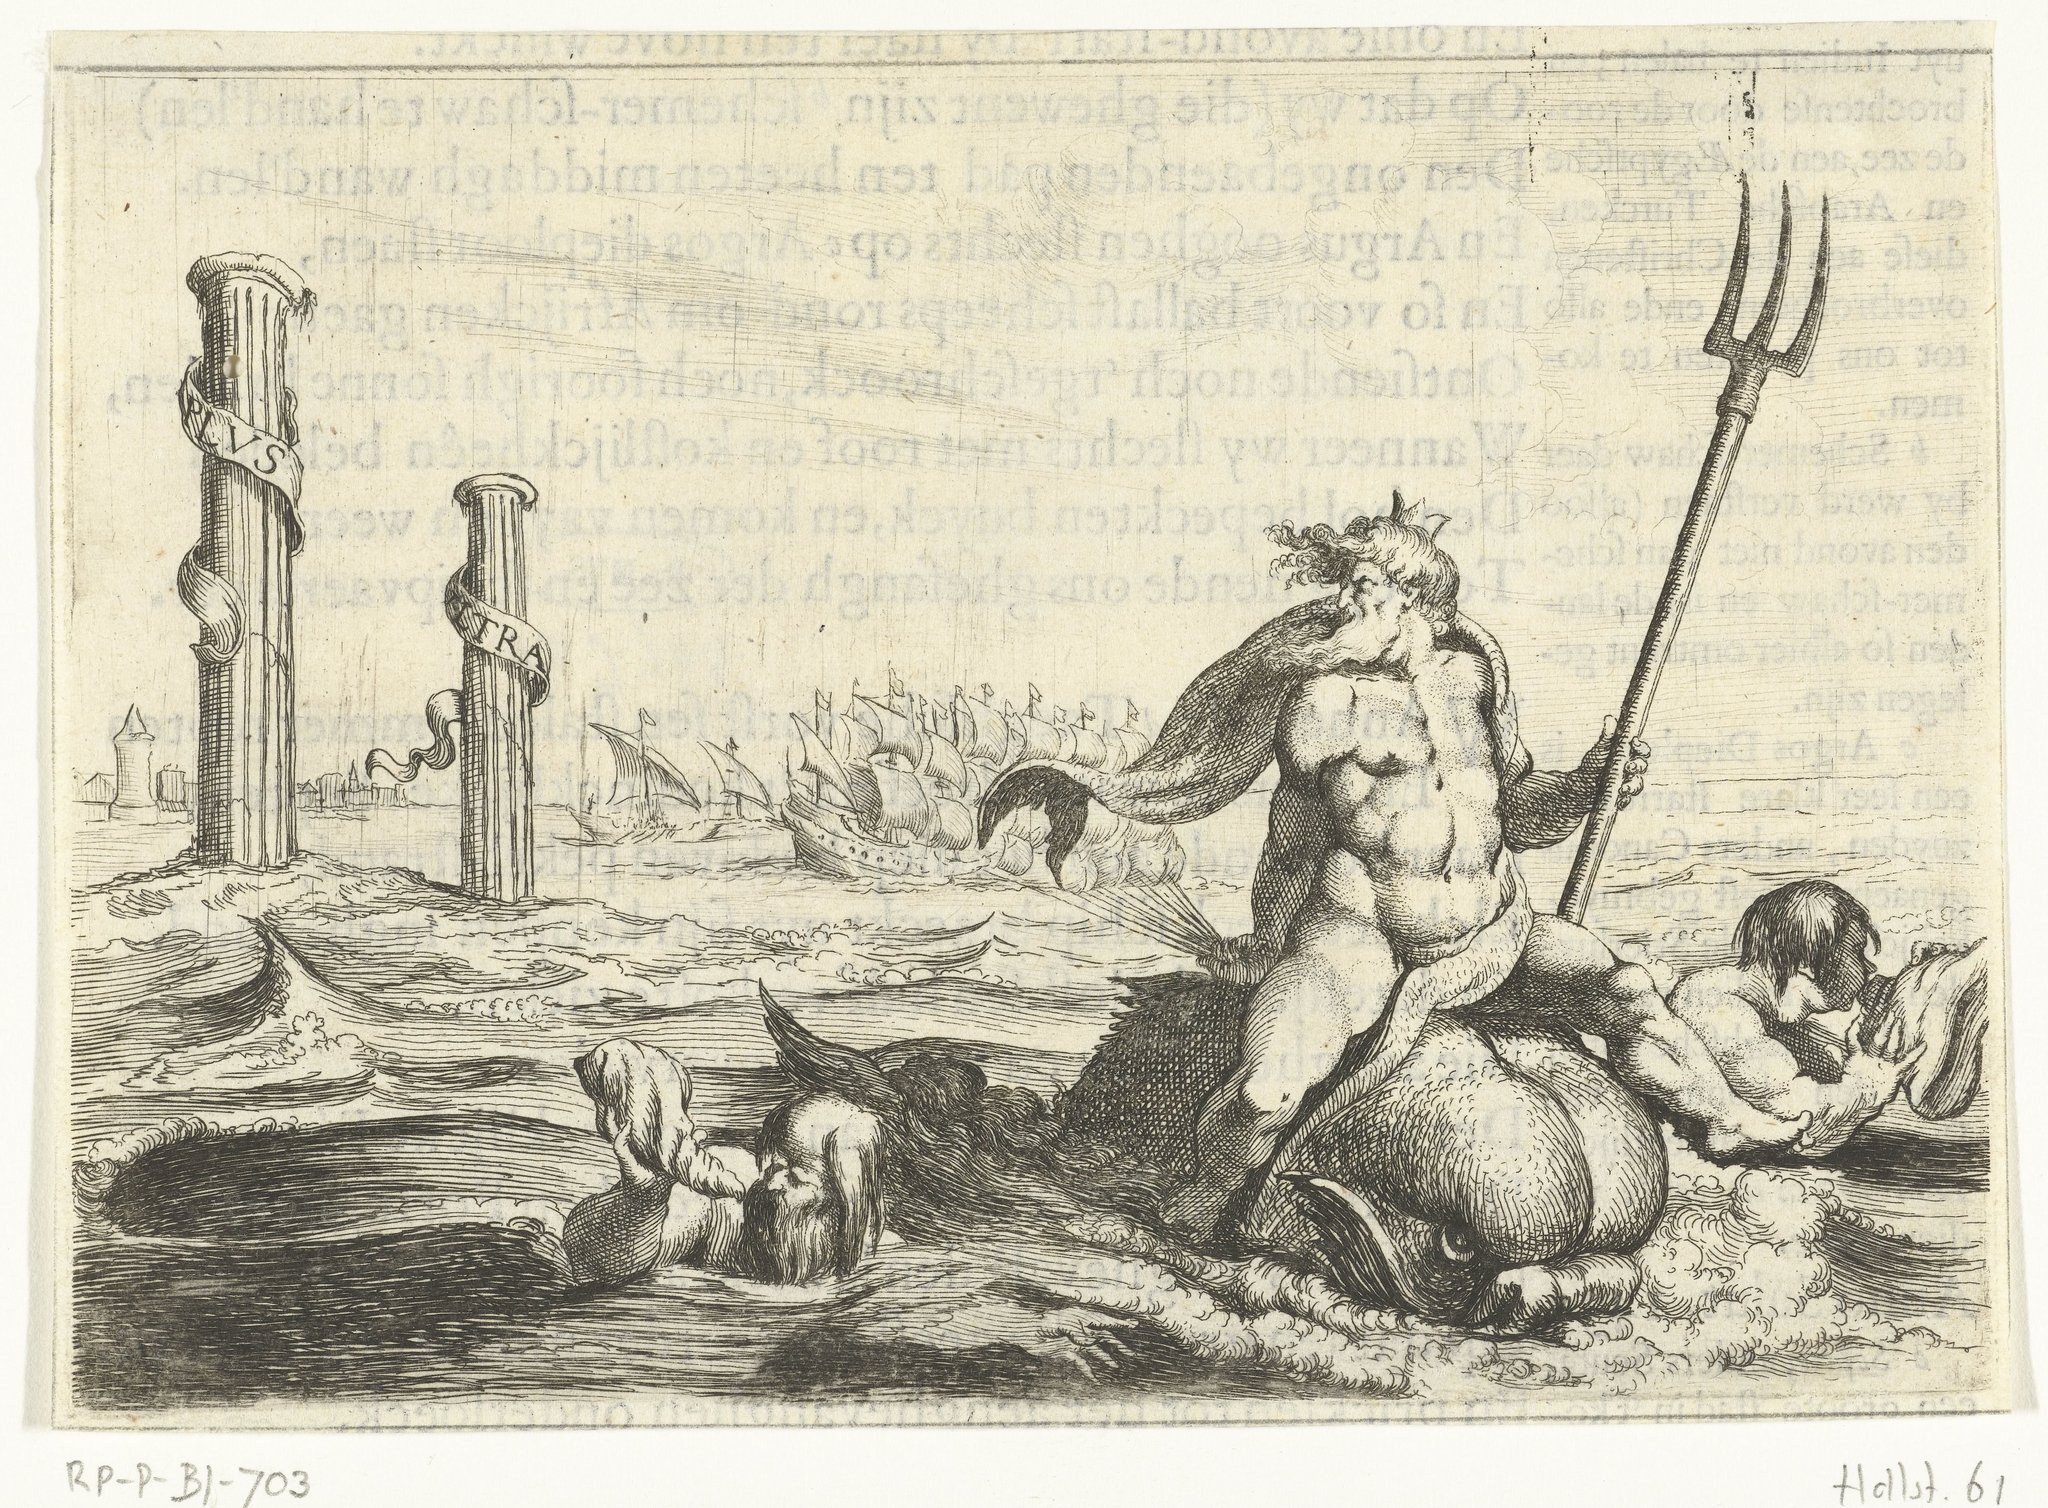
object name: print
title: Neptunus met de zuilen van Hercules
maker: willem basse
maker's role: draughtsman, print maker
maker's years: 1613-1672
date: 1632-1634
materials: paper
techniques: engraving, etching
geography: northern netherlands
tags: (story of) neptune (poseidon), pillars of hercules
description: Neptunus rijdend op een dolfijn, begeleid door tritonen, draait zich om naar de zuilen van Hercules met het opschrift Plus Ultra. Op de achtergrond een vloot op zee. Bedrukt op achterzijde met tekst in het Nederlands. .